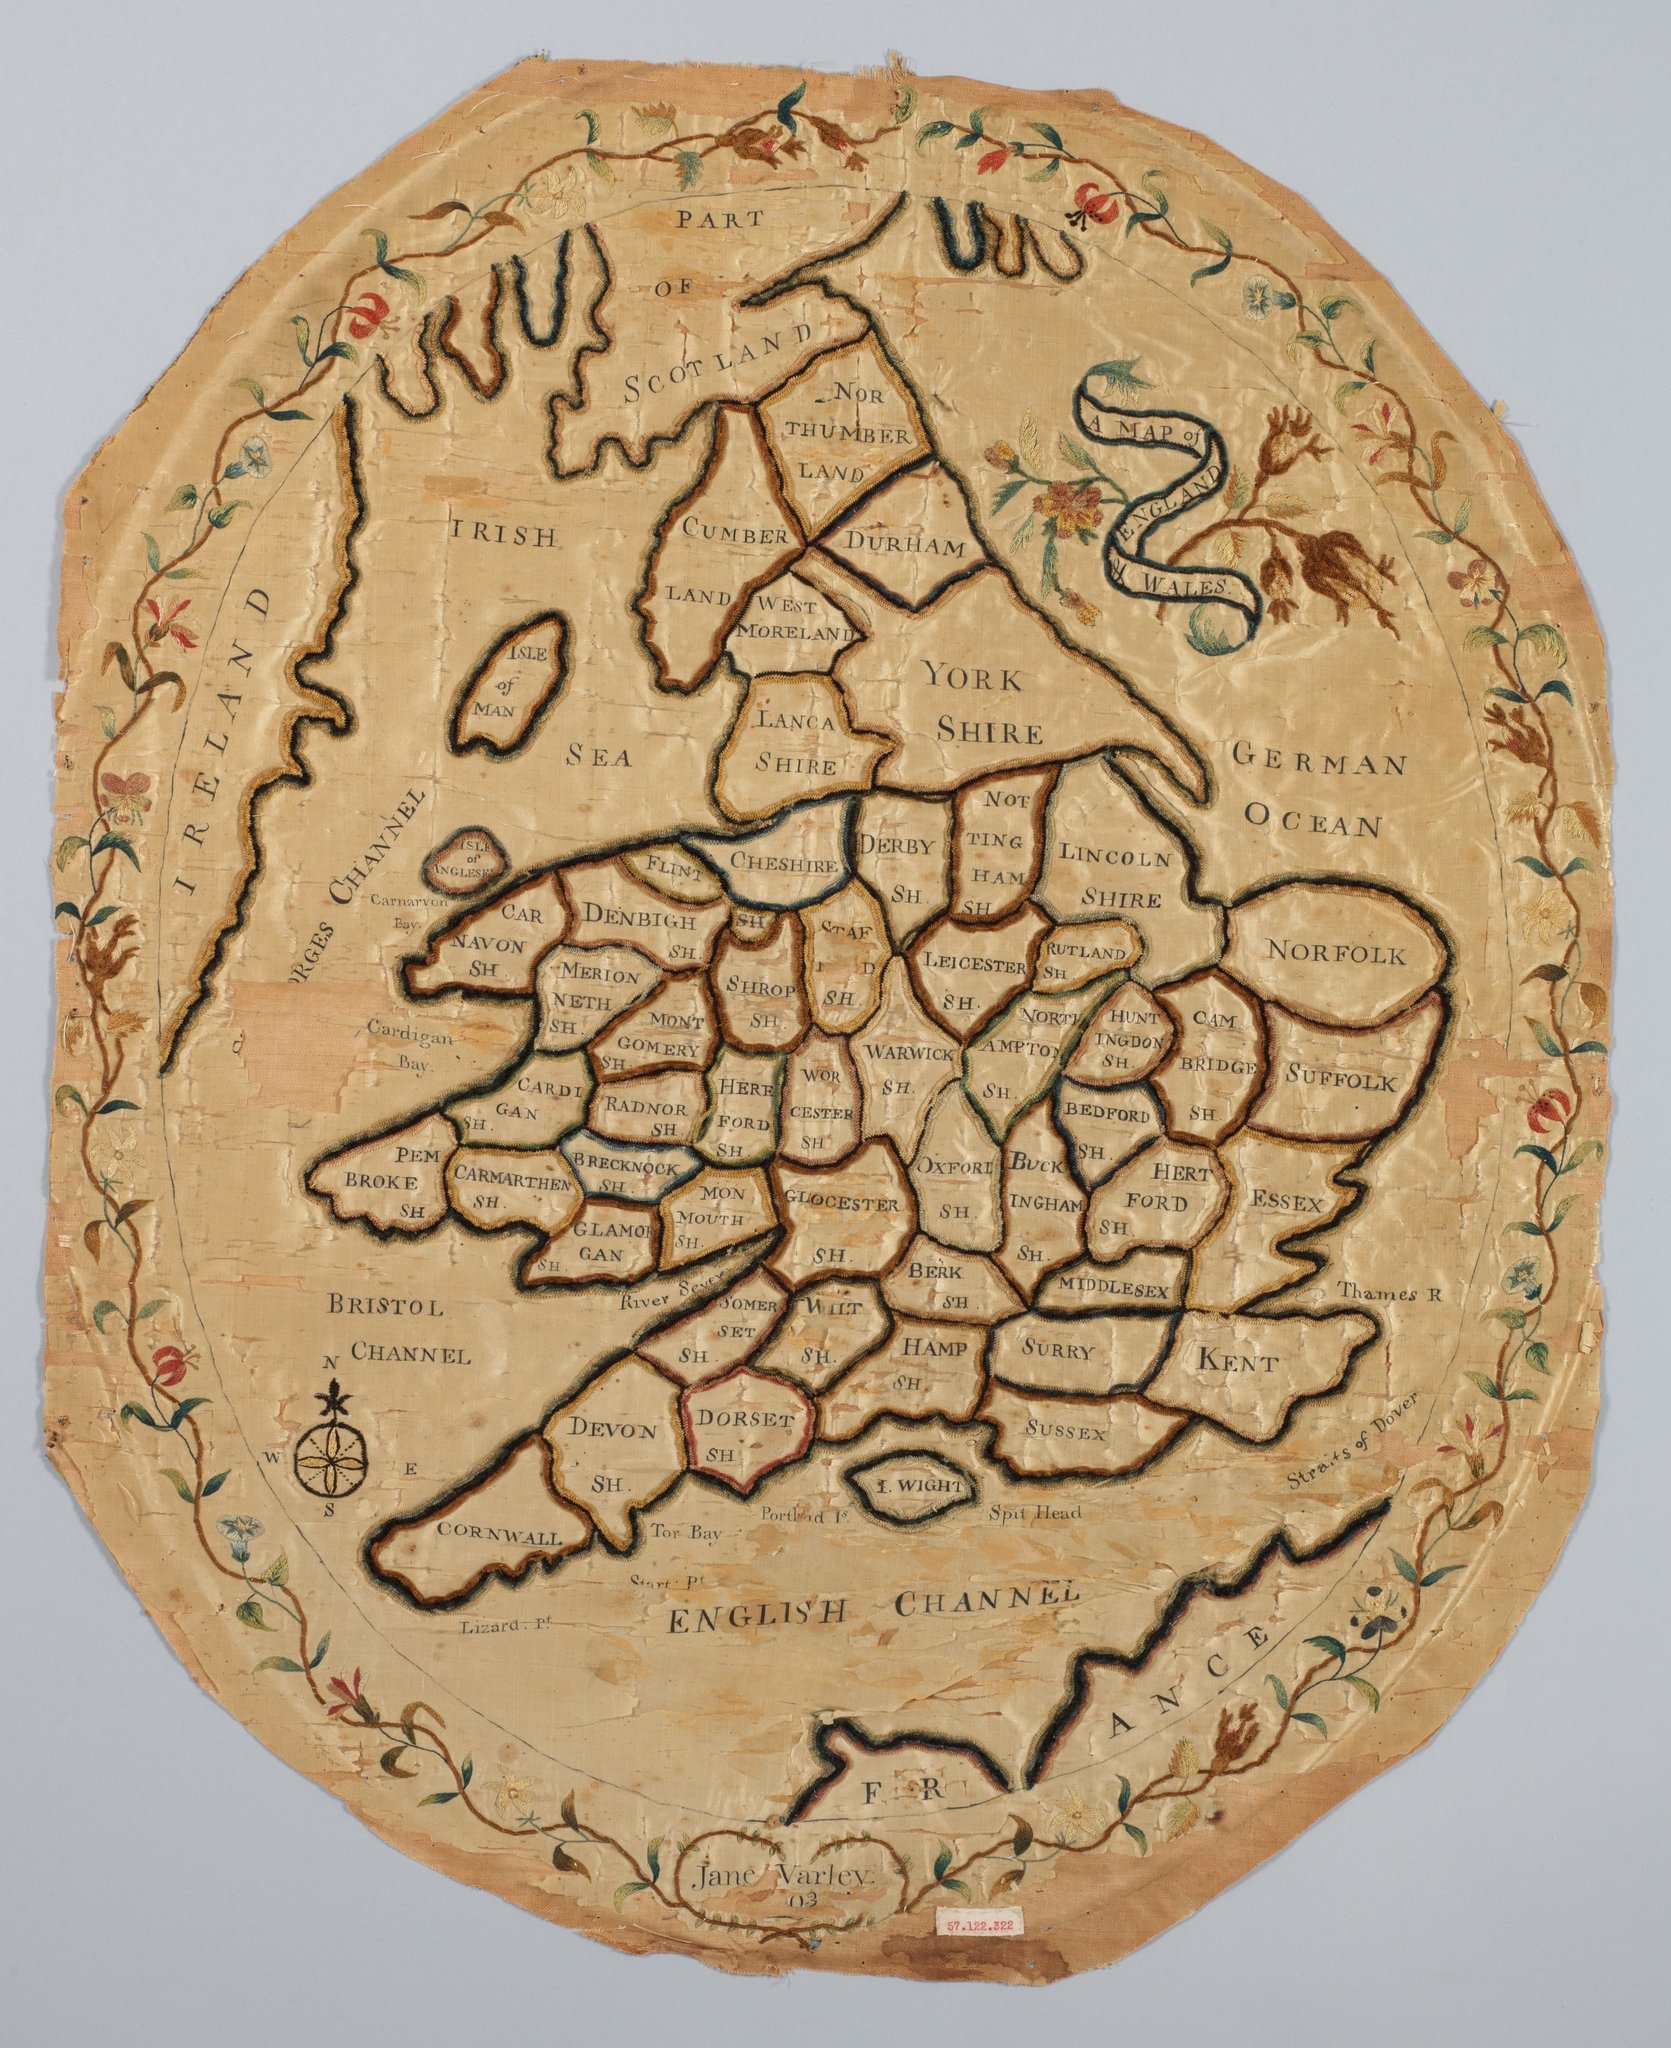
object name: sampler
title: Embroidered map sampler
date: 1803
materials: silk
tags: maps